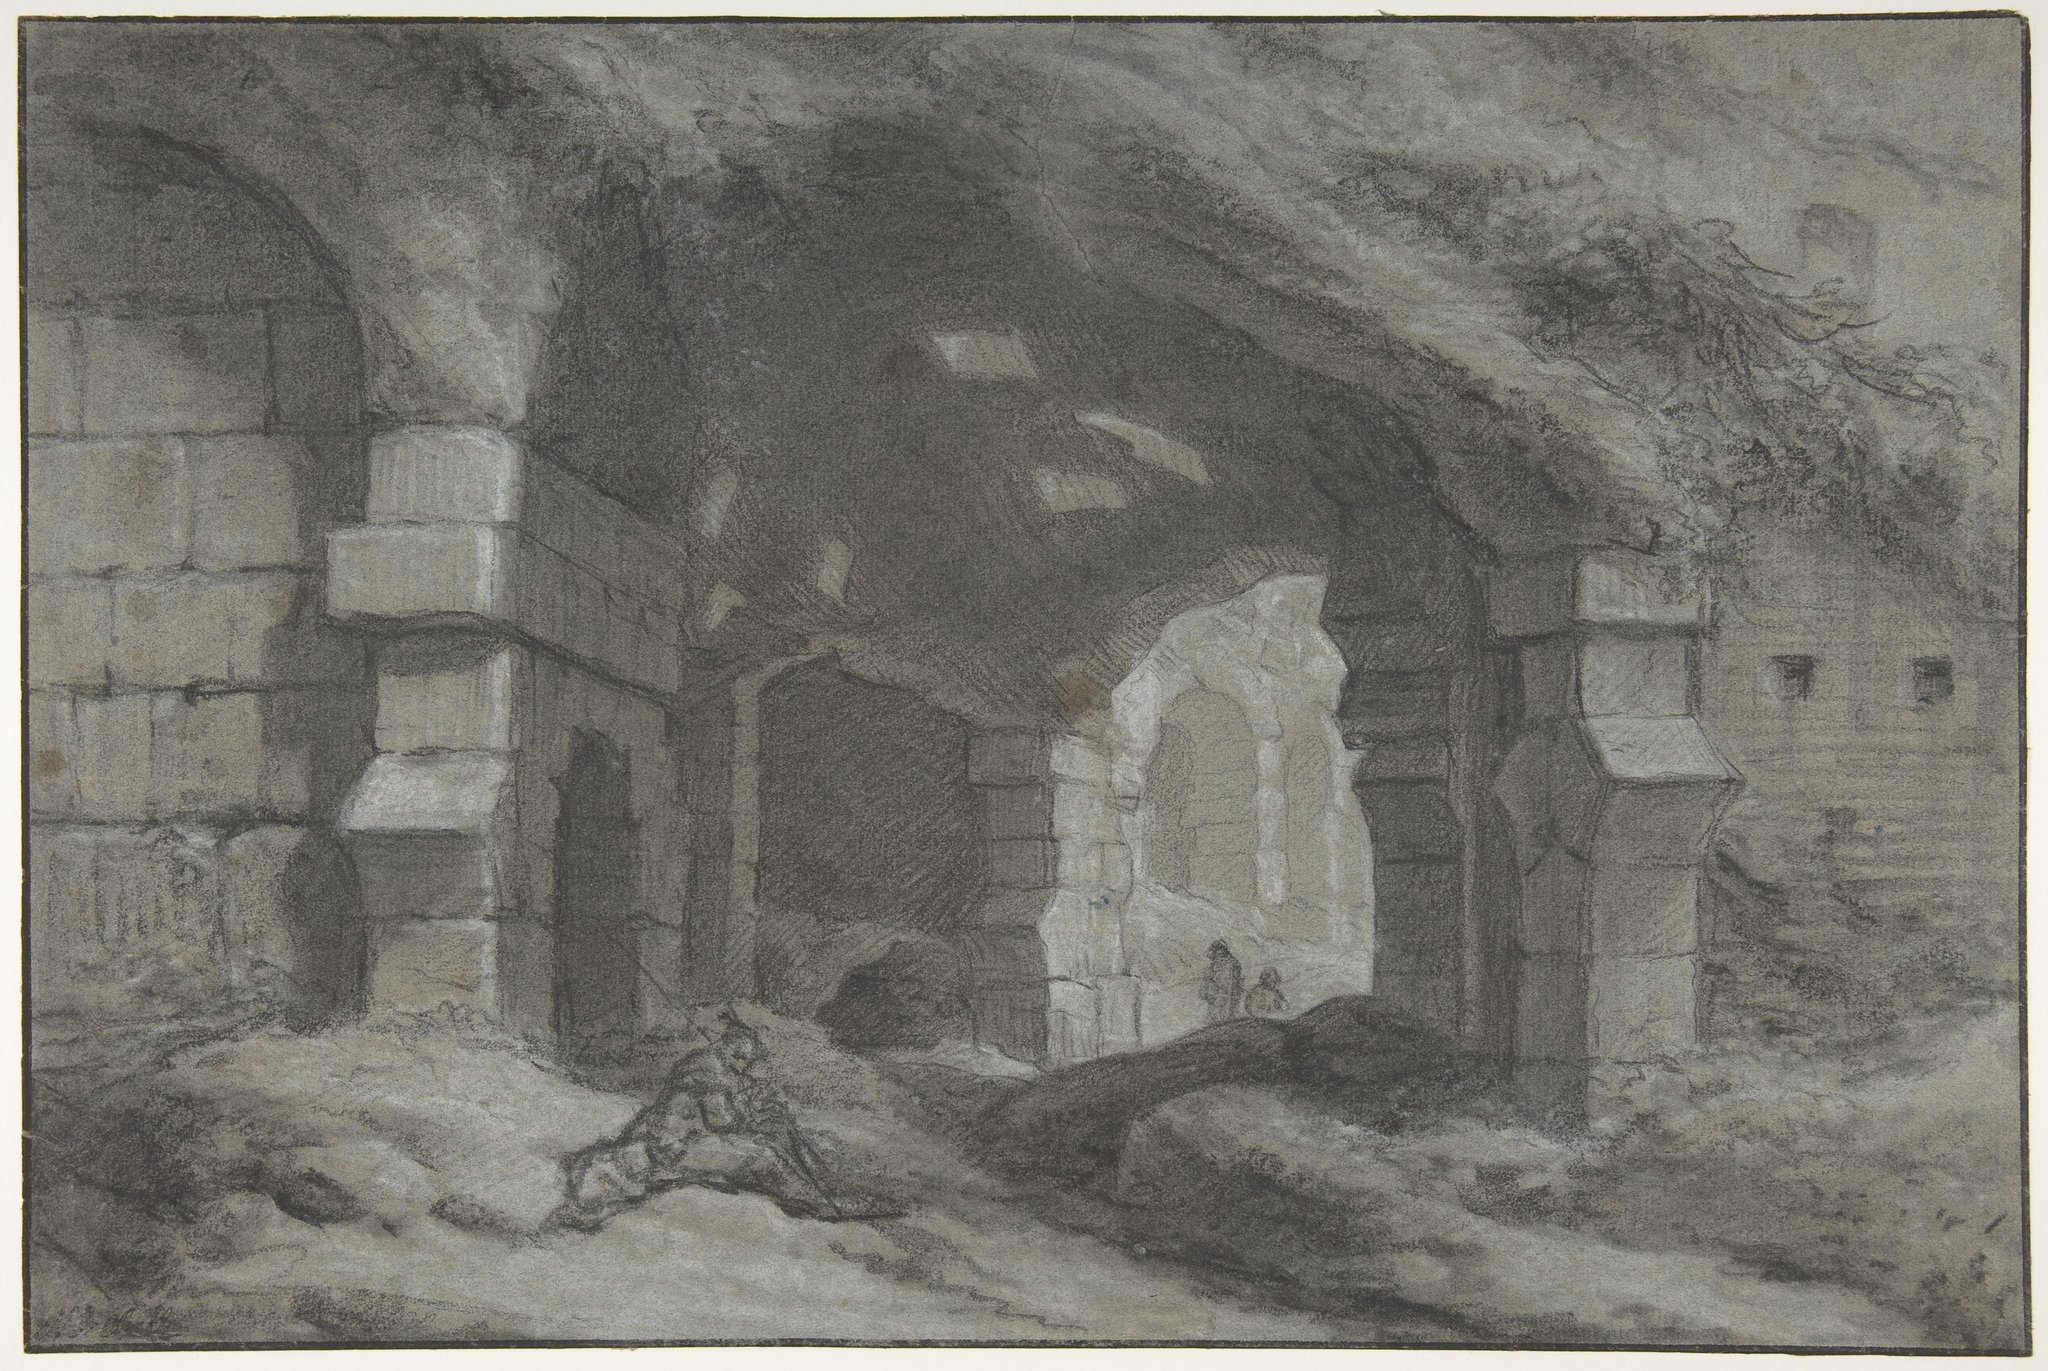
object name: drawing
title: View Within the Colosseum, Rome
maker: charles michel ange challe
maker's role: artist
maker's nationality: french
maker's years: 1718-1778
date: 1701-1800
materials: chalk, ink, paper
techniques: heightening, pen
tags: architecture,ruins,rome